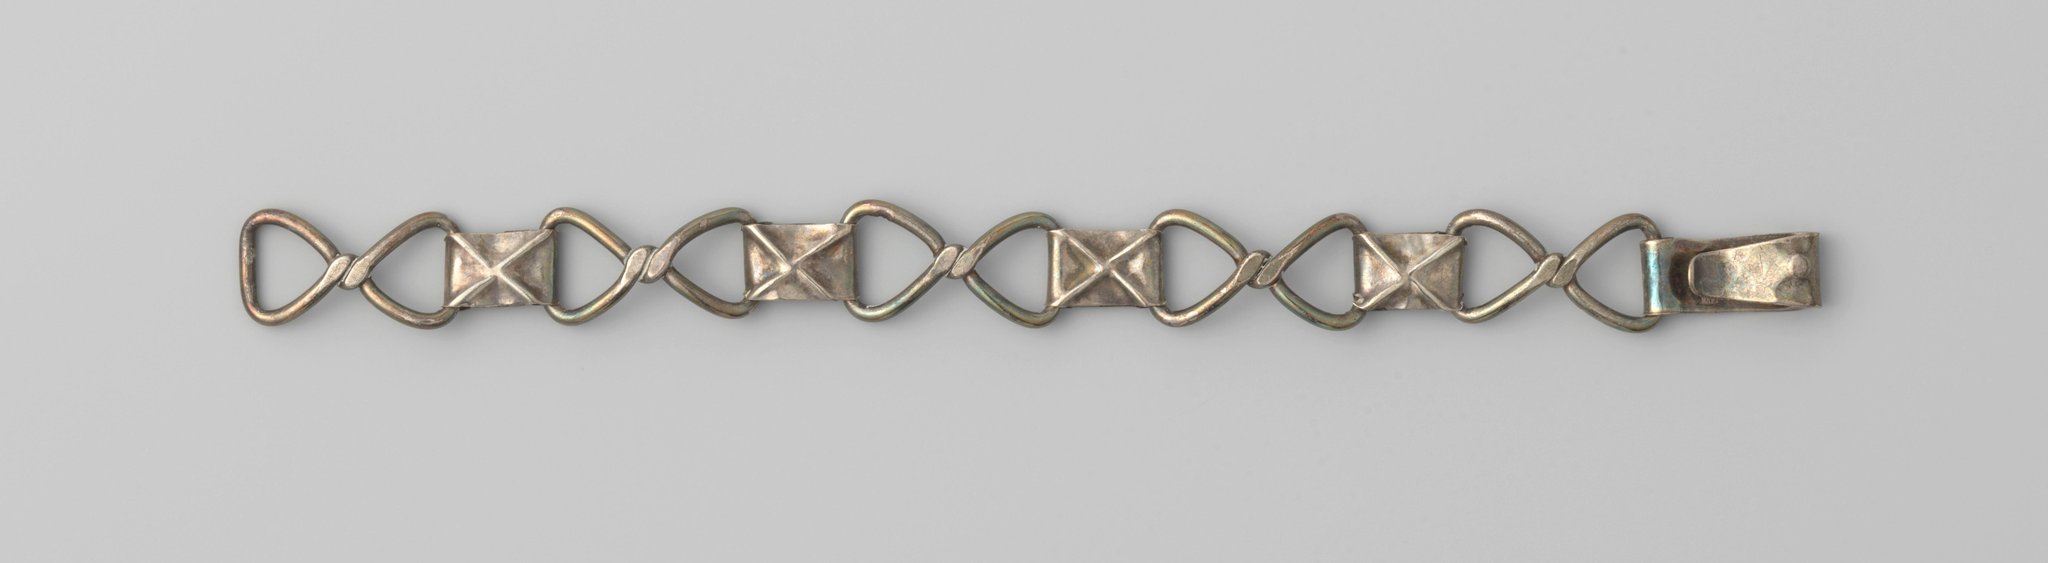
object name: chain bracelet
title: Schakelarmband van zilverdraad met hamerslag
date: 1933-1953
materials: silver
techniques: hammering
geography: netherlands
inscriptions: alloy mark, : ‘4’, maker's mark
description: Schakelarmband van zilverdraad met hamerslag met een haaksluiting en een gewichtsaanduidend teken (4).